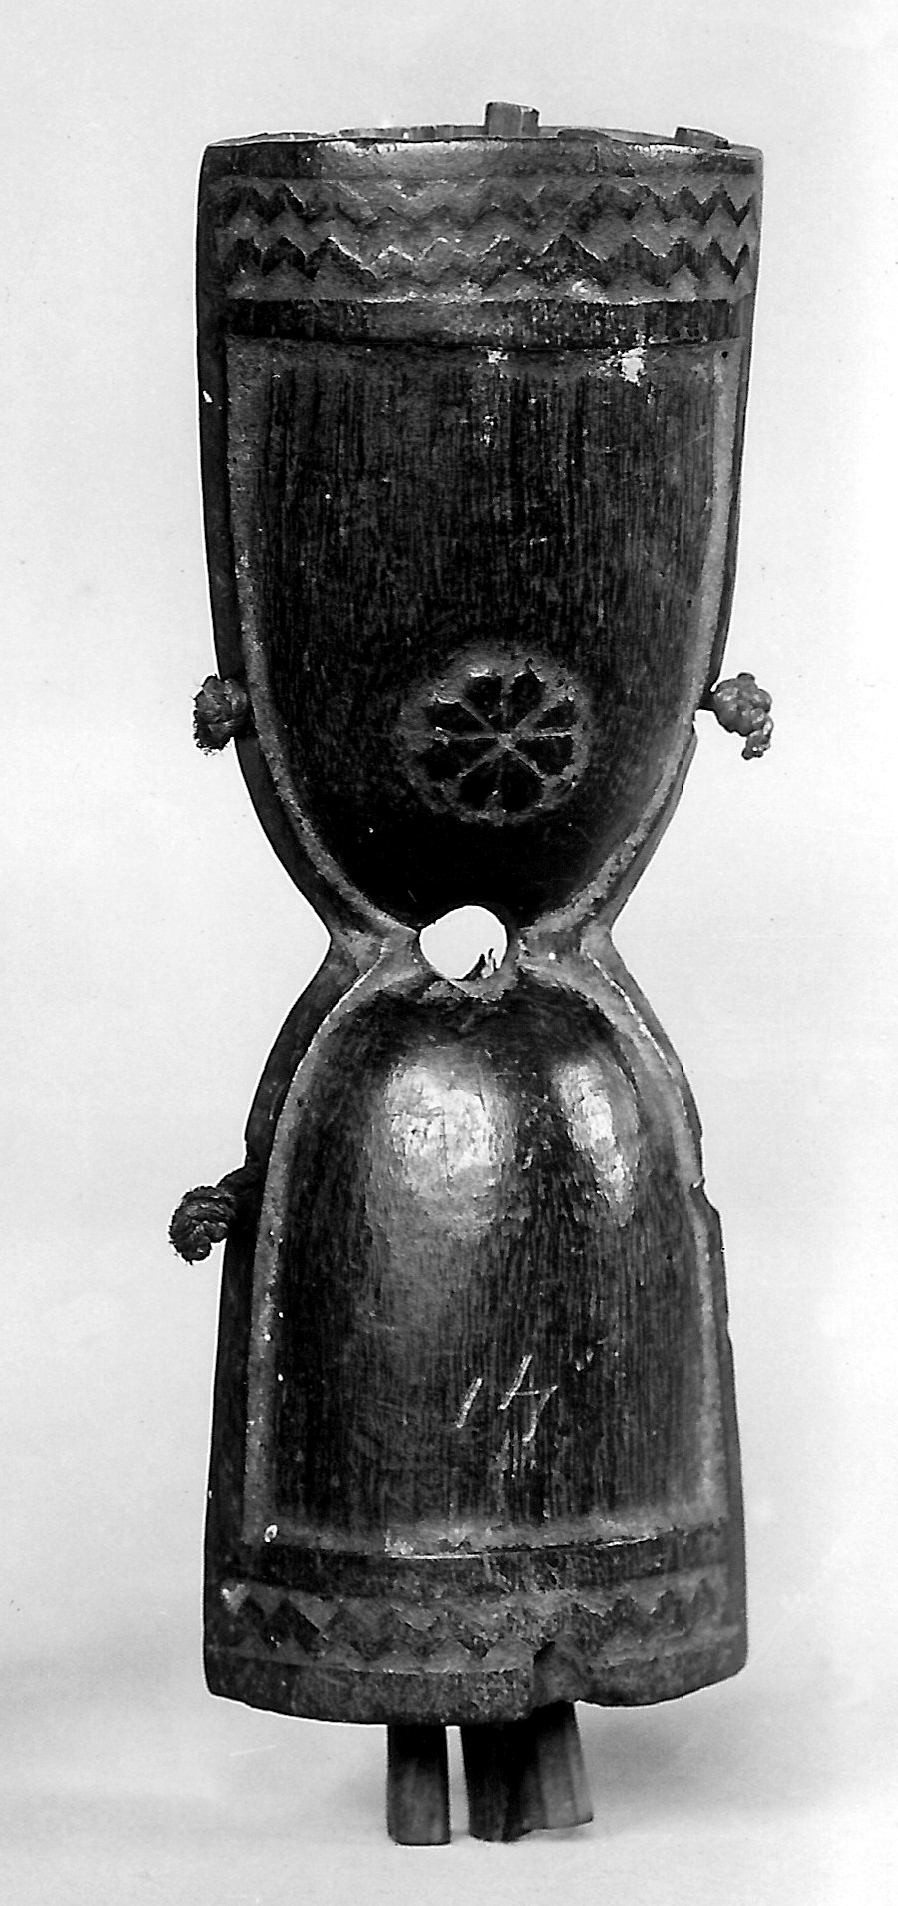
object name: kunda bell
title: Kunda (bell)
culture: congolese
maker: mayumba people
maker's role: maker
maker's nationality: congo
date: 1867-1900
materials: wood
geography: congo